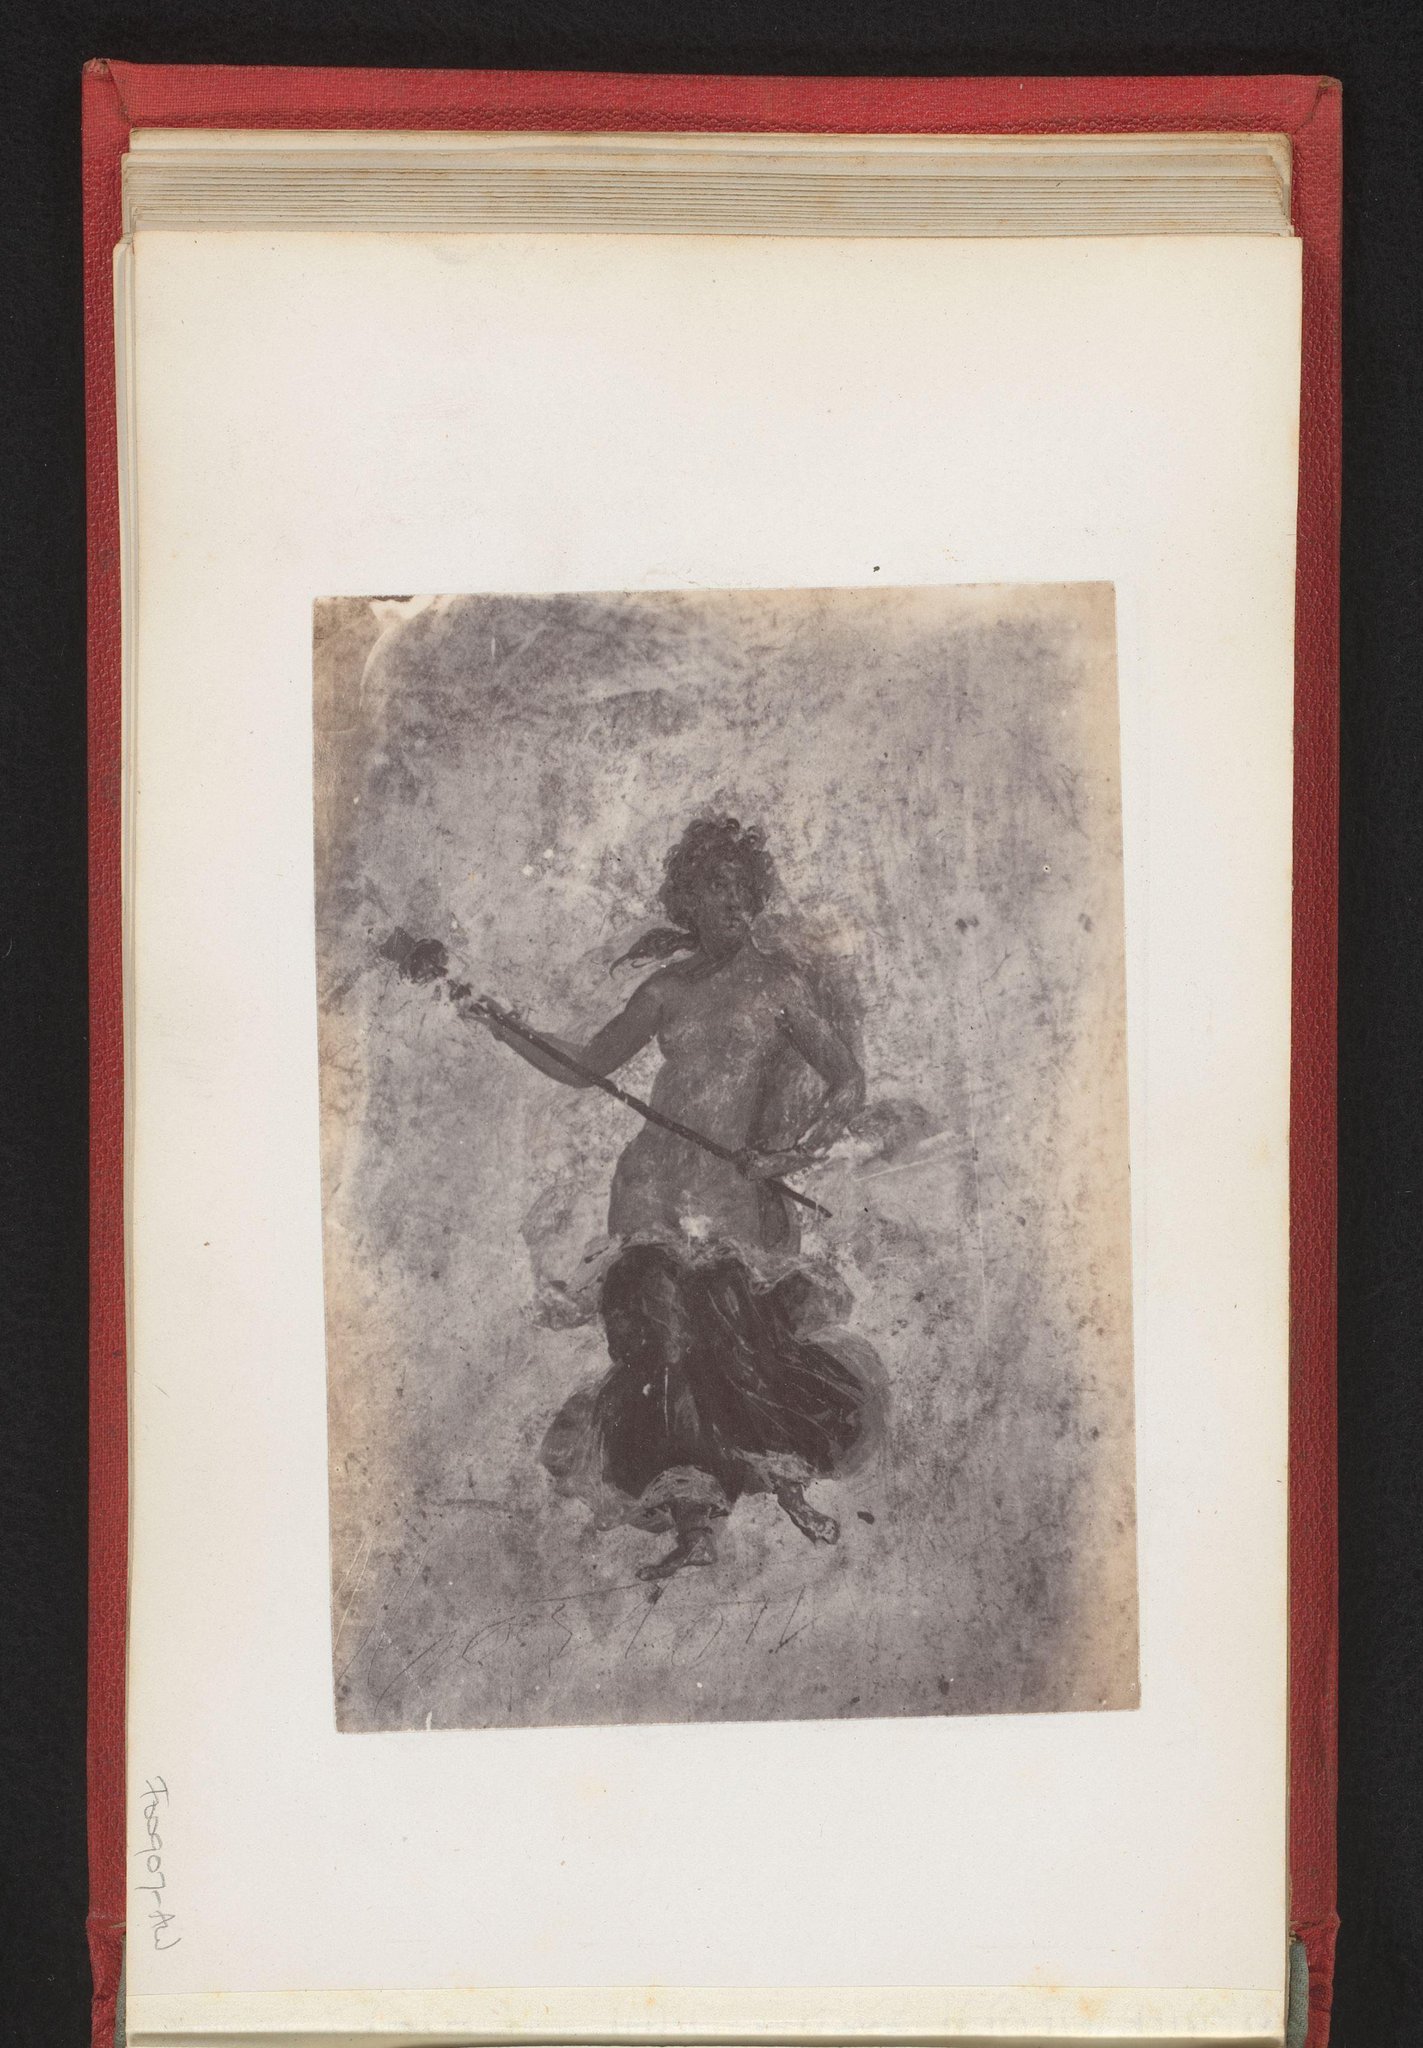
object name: reproduction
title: Fotoreproductie van een fresco te Pompeï van een halfnaakte vrouw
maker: Anonymous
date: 1860-1900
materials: photographic support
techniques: albumen print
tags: (almost) naked ~ ascetic life, painting, drawing and the graphic arts, pompeii